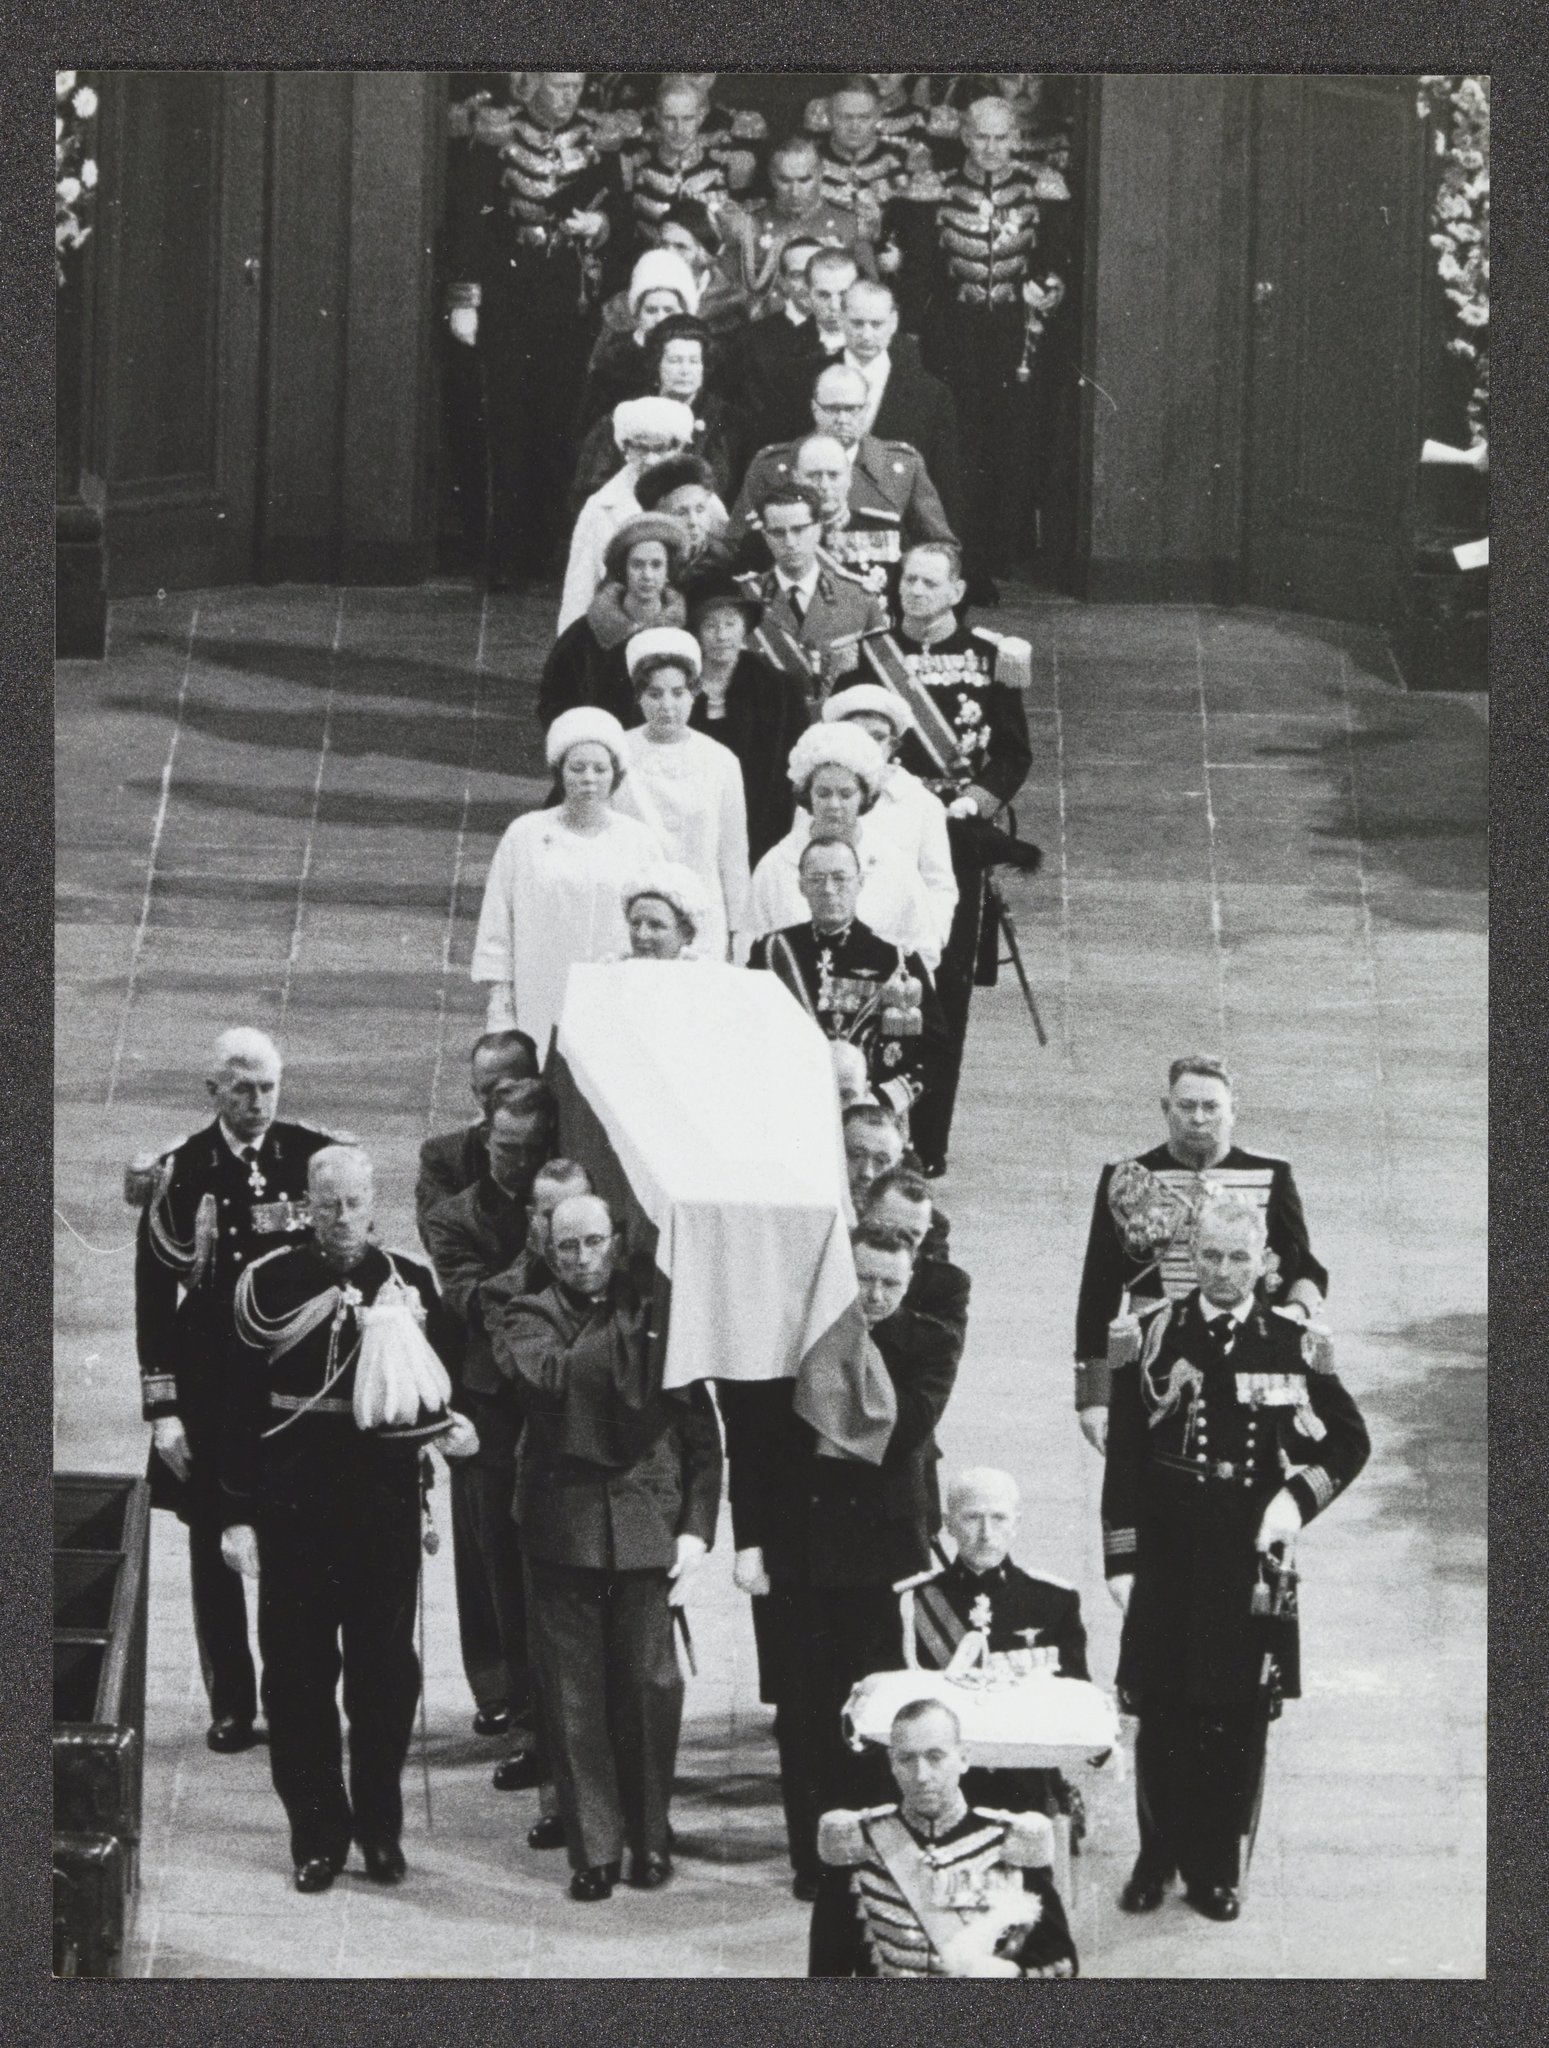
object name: photograph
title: Begrafenis van koningin Wilhelmina in Delft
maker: Anonymous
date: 1962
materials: photographic support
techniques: gelatin silver print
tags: print maker, wilhelmina of the netherlands, utrecht, bernhard (prins der nederlanden), beatrix (koningin der nederlanden), juliana of the netherlands, delft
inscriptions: stamp: ‘copyright anefo kerkstraat 310 Amsterdam -C’